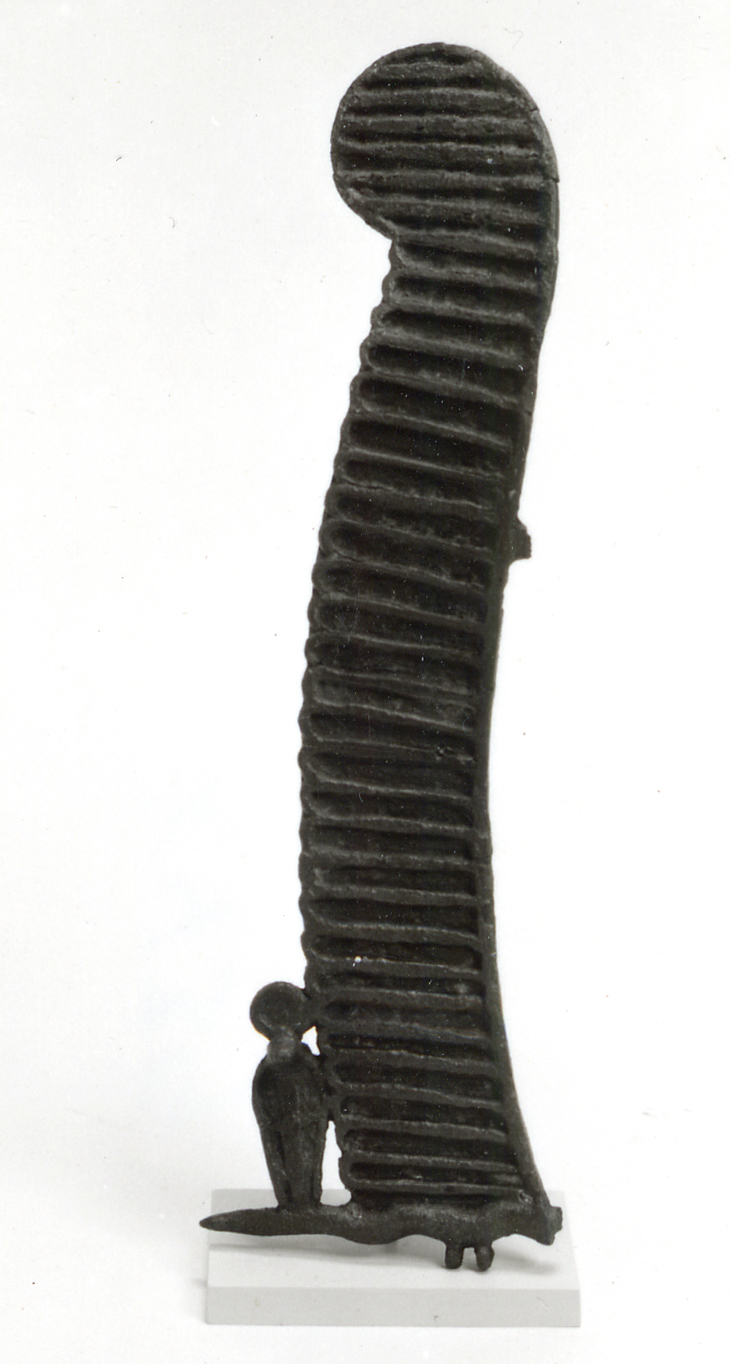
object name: headdress attachment, feather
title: Attachment feather for a large crown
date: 595-530 BCE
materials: bronze